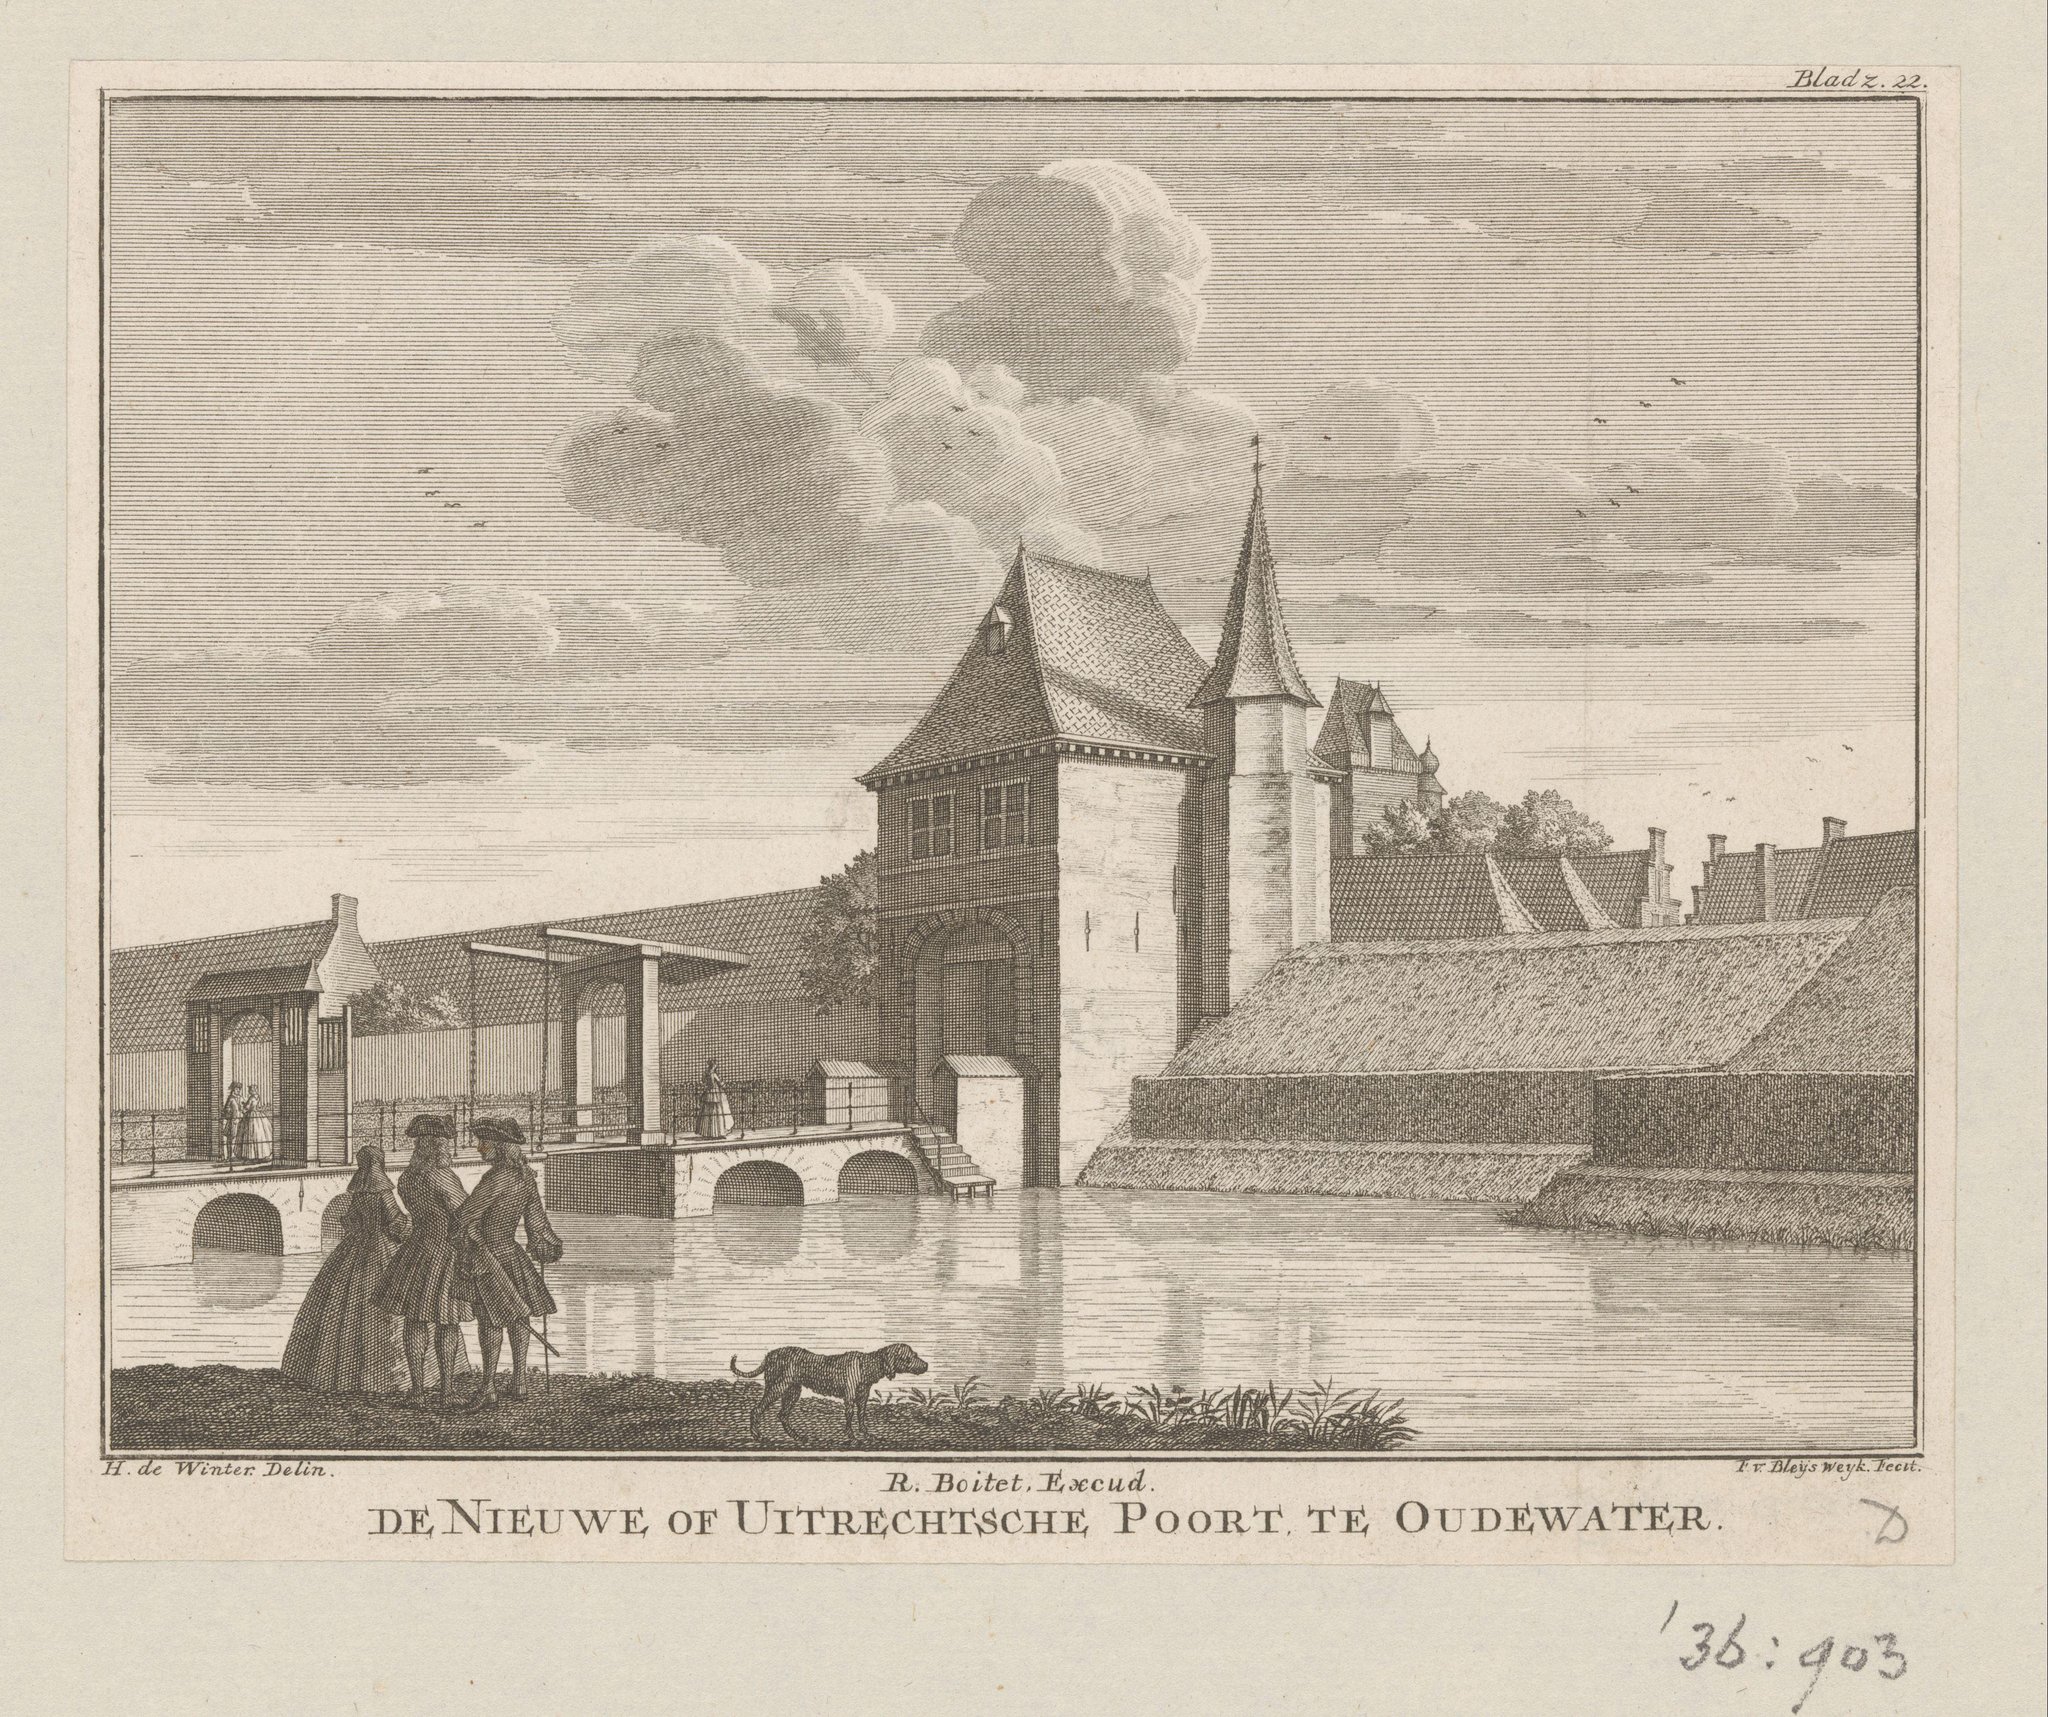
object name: print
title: De Nieuwe of Uitrechtsche poort te Oudewater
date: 1747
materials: paper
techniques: engraving, etching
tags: bridge in city across river, canal, etc., city-gate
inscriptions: collector's mark: Lugt 2760, collector's mark: Lugt 2228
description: Prent uit: Kinschot, Gasparus Rudolphus. Beschryving der stad Oudewater (...). Delft: Reinier Boitet, 1747, p. 22.